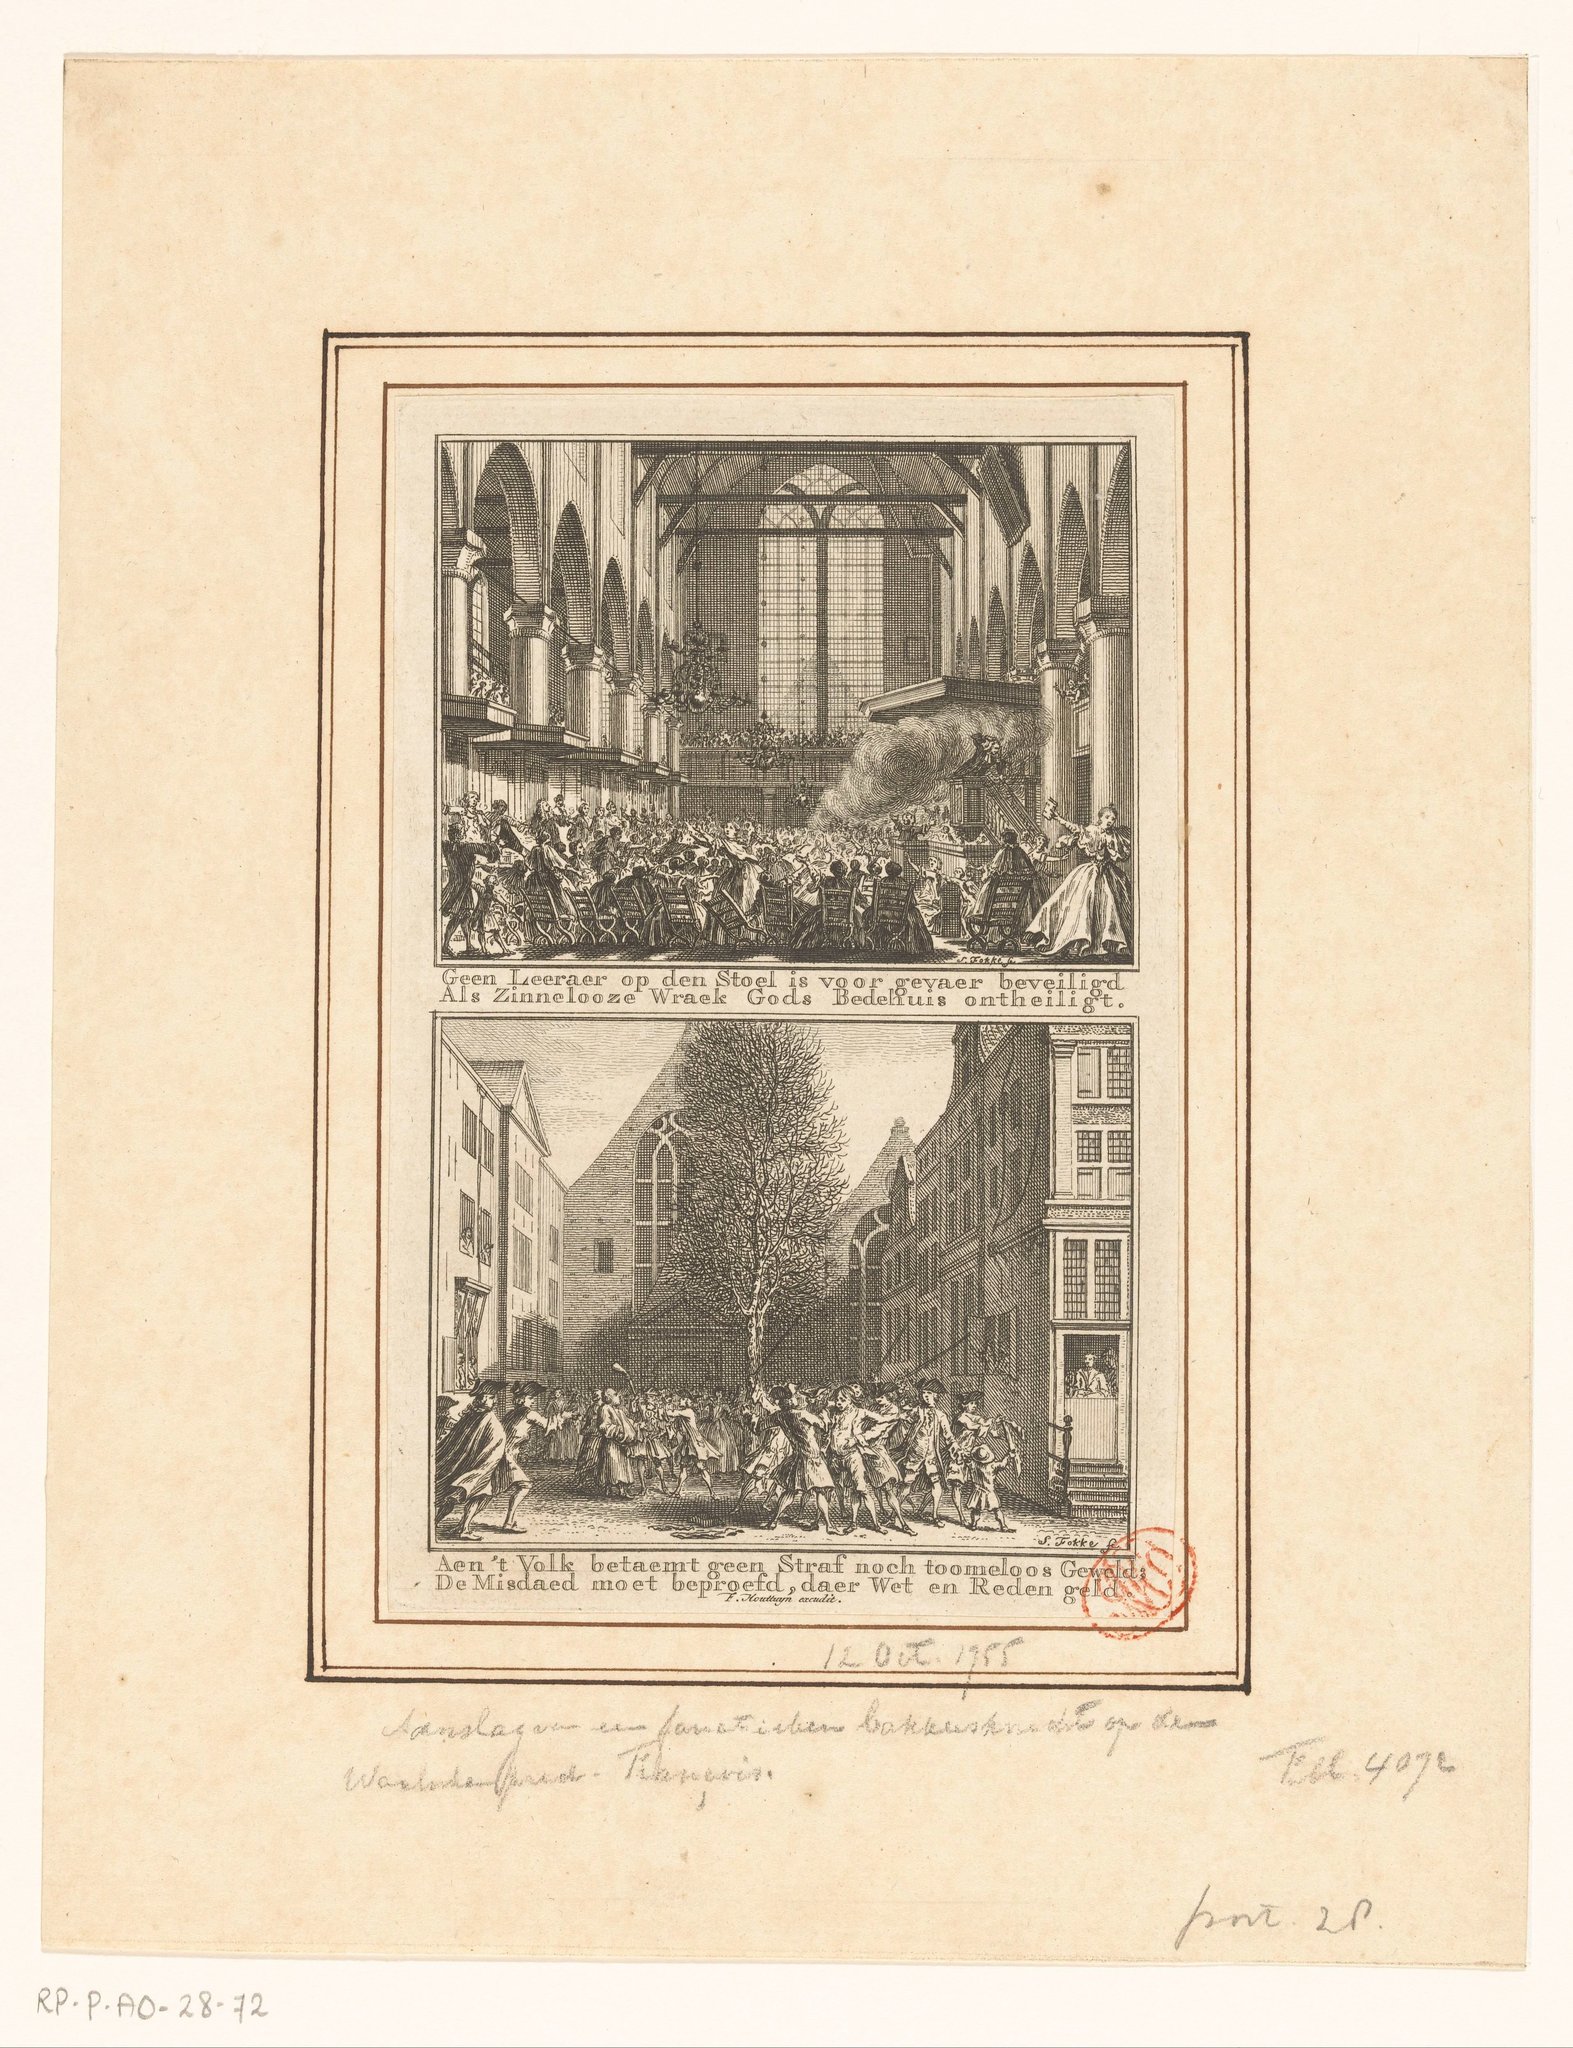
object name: book illustration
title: Aanslag op de predikant J.H. François in de Waalse Kerk / Onrust bij de Waalse Kerk na de aanslag, 1755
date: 1755-1756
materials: paper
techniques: engraving, etching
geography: amsterdam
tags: church (exterior), interior of church, murder, street-fights, riots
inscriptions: collector's mark: Lugt 2228, collector's mark: Lugt 195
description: Prent ook gebruikt in: Nederlandsche Jaerboeken, inhoudende het verhael van de merkwaerdigste geschiedenissen (…) voor het jaer MDCCLV / Nederlandsche Jaerboeken, inhoudende het verhael van de merkwaerdigste geschiedenissen (…) Negende deel. 1755. Amsterdam: Frans Houttuyn, s.a. [1755-1756], tussen p. 922 en 923.